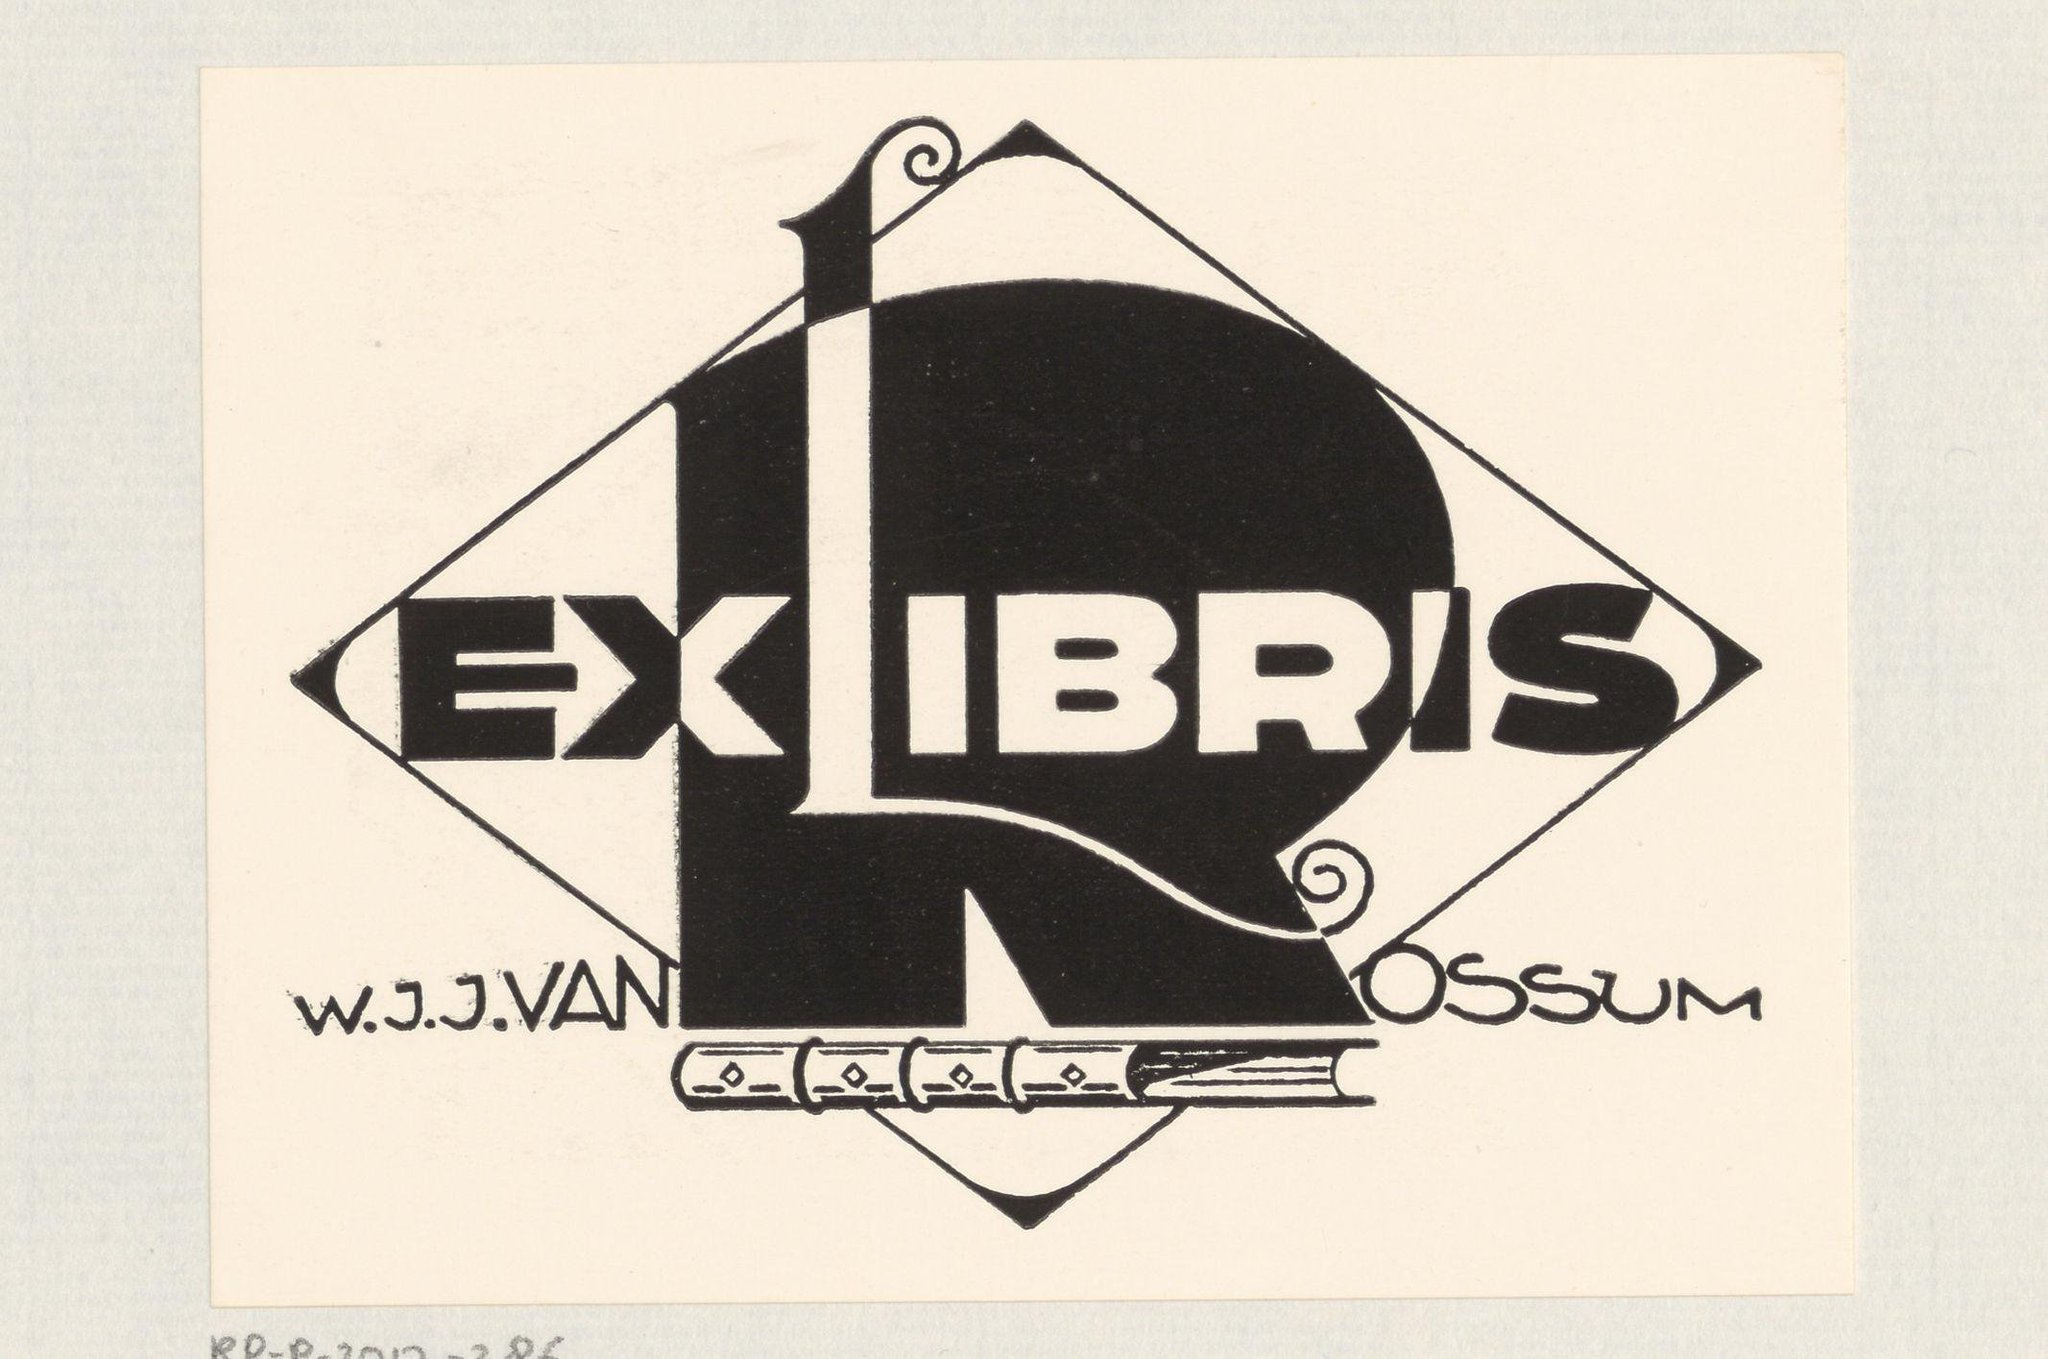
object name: bookplate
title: Ex libris van W.J.J. van Rossum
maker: antonius cornelis van den berg (ton)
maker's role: print maker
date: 1944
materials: paper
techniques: printing block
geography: netherlands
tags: w.j.j. van rossum, book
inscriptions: workshop stamp: ‘Ontw: A.C. van den Berg / Cliché 1944’